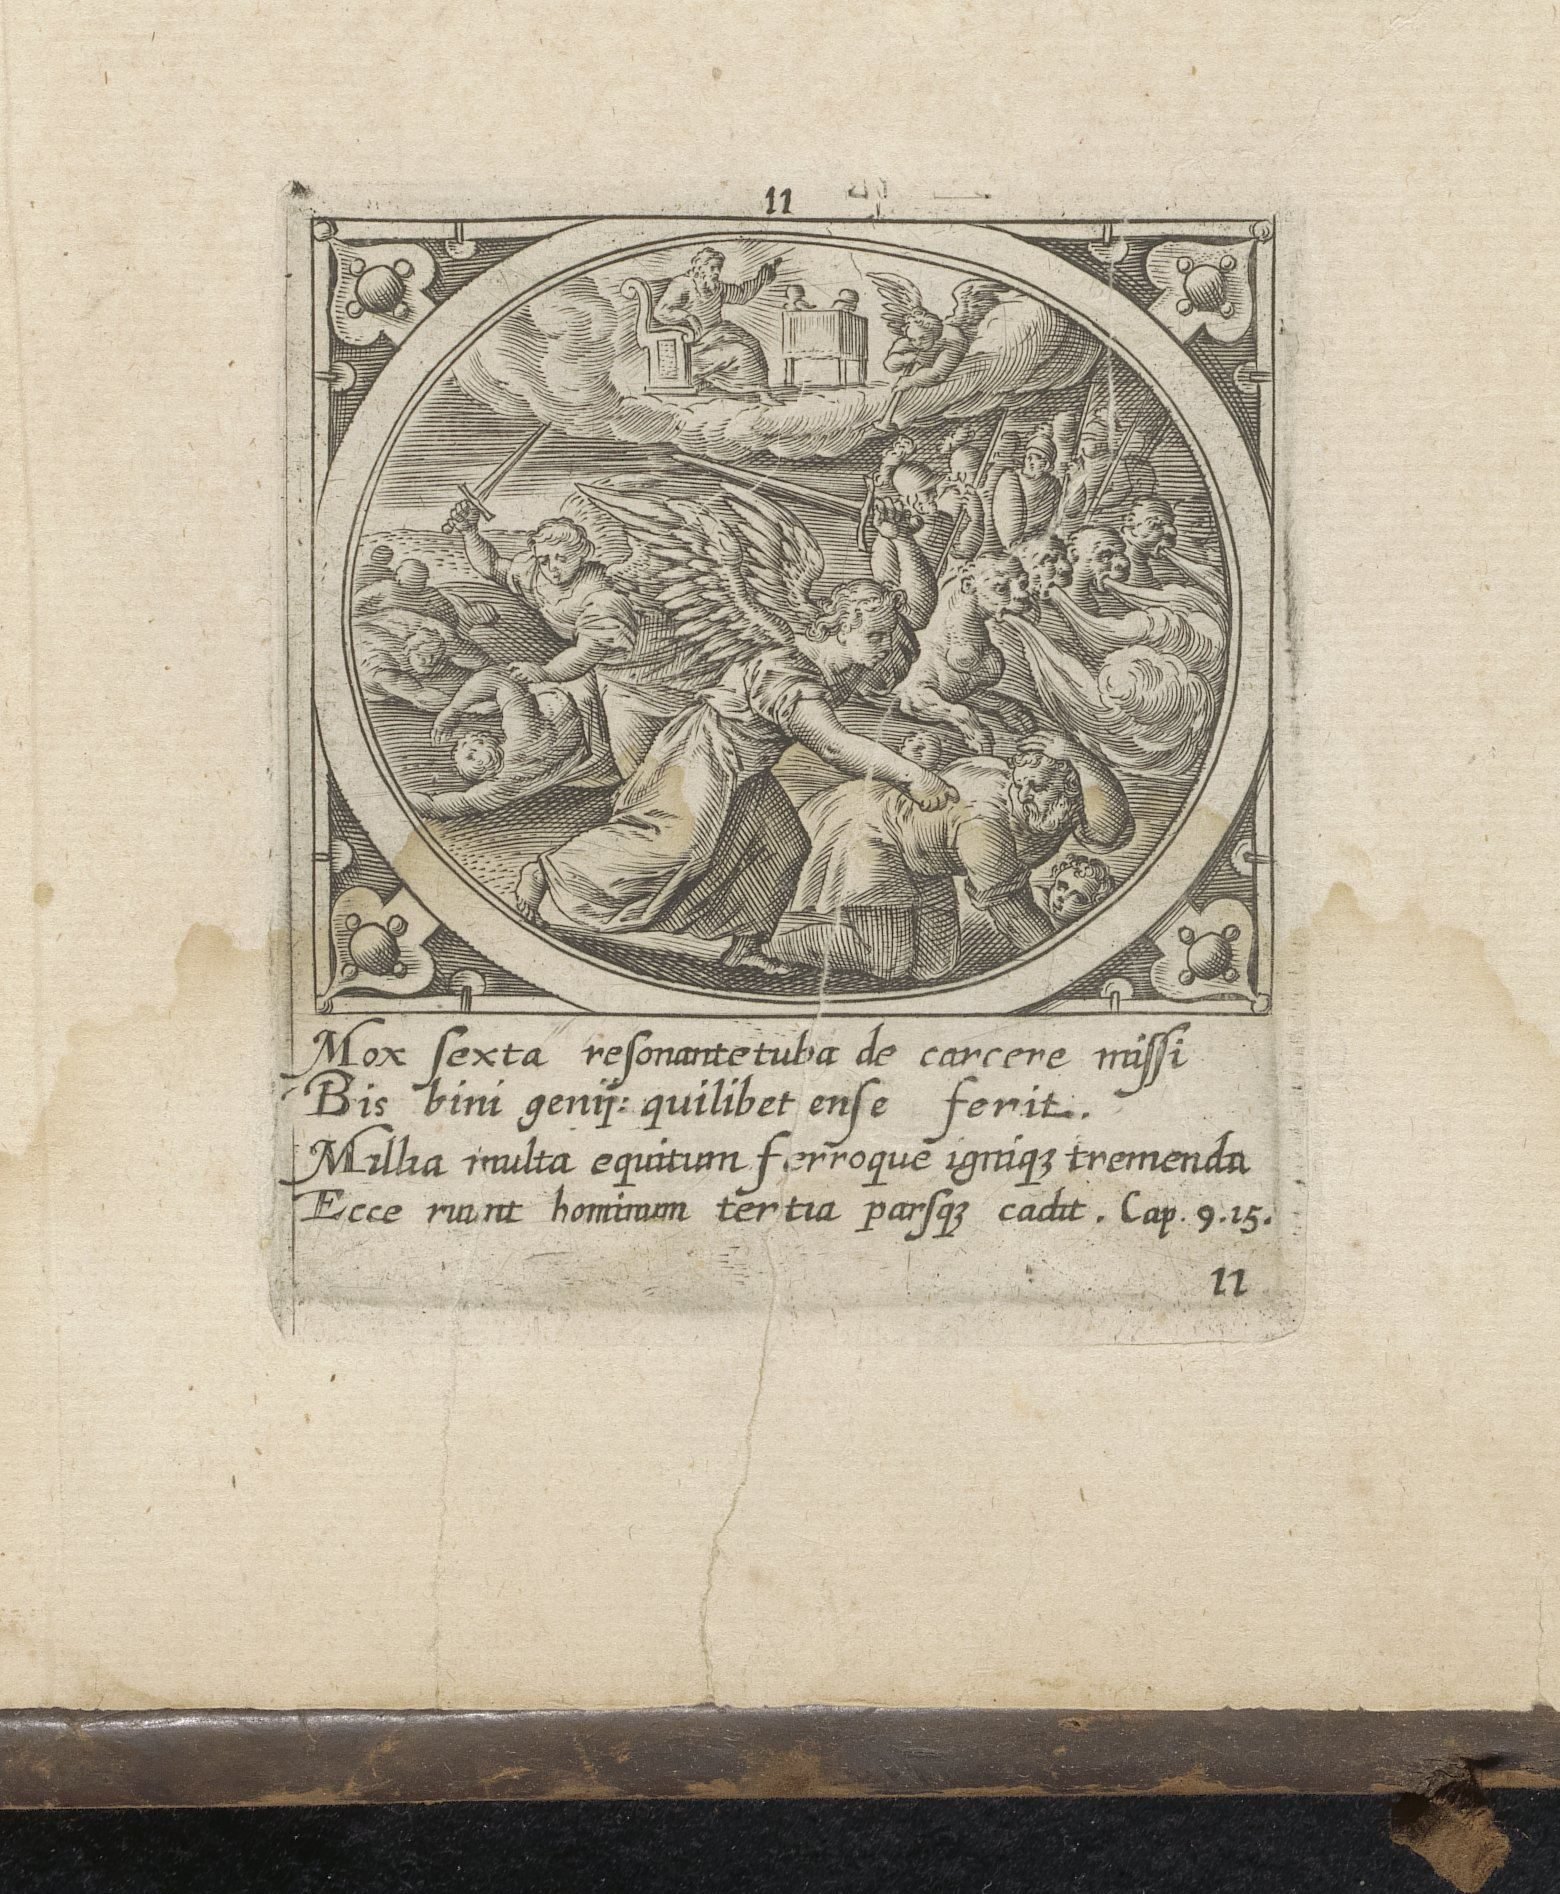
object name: print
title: Icones Revelationum S Iohs Evangeliste in Pathmo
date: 1585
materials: paper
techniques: engraving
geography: alkmaar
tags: the sixth of the seven angels sounds the trumpet: the four angels of destruction are released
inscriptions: number: ‘209’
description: De zesde engel blaast op de bazuin. Naast de engel zit God de Vader op zijn troon en staat het gouden altaar met de vier horens waar een stem uitkomt die opdraagt dat de vier engelen die gevangen zitten moeten worden bevrijd. De engelen en de ruiters op paarden met leeuwenkoppen roeien een derde van de mensheid uit. Onder de voorstelling een verwijzing in het Latijn naar de Bijbeltekst in Op. 9:15. Deze prent maakt deel uit van een album.